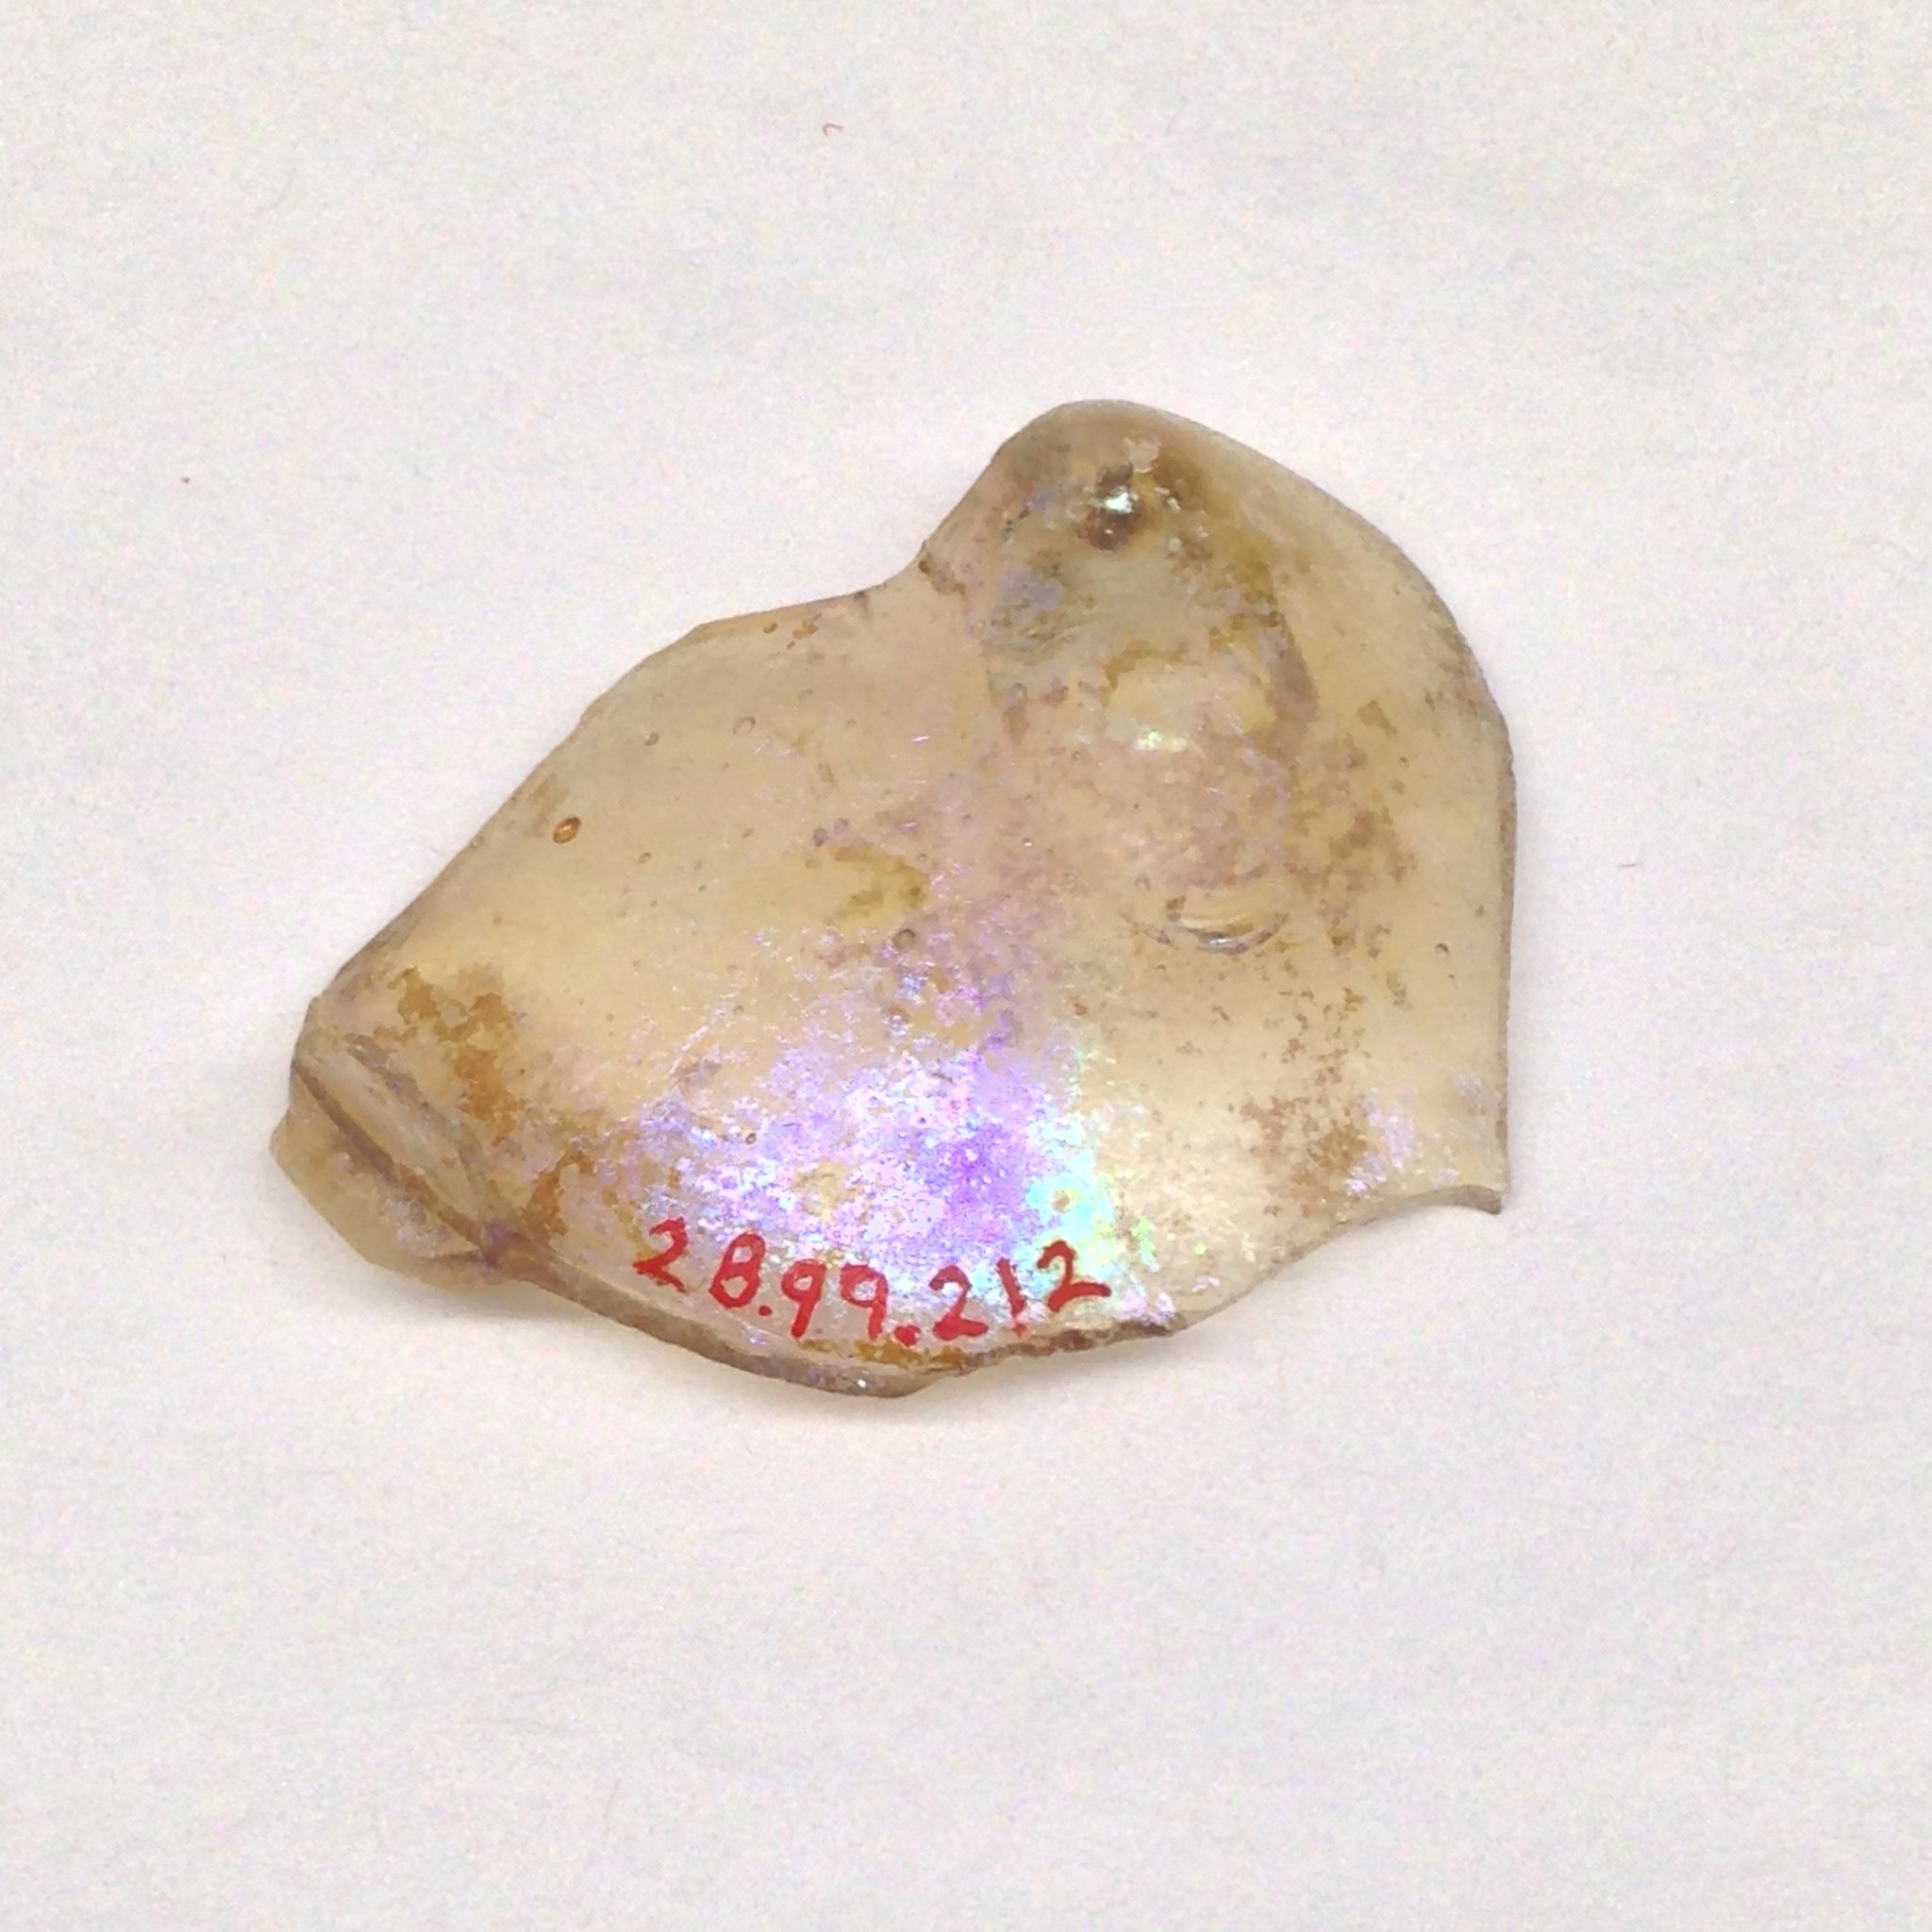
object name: fragment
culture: european or middle eastern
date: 1150-1250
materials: ceramic, glass